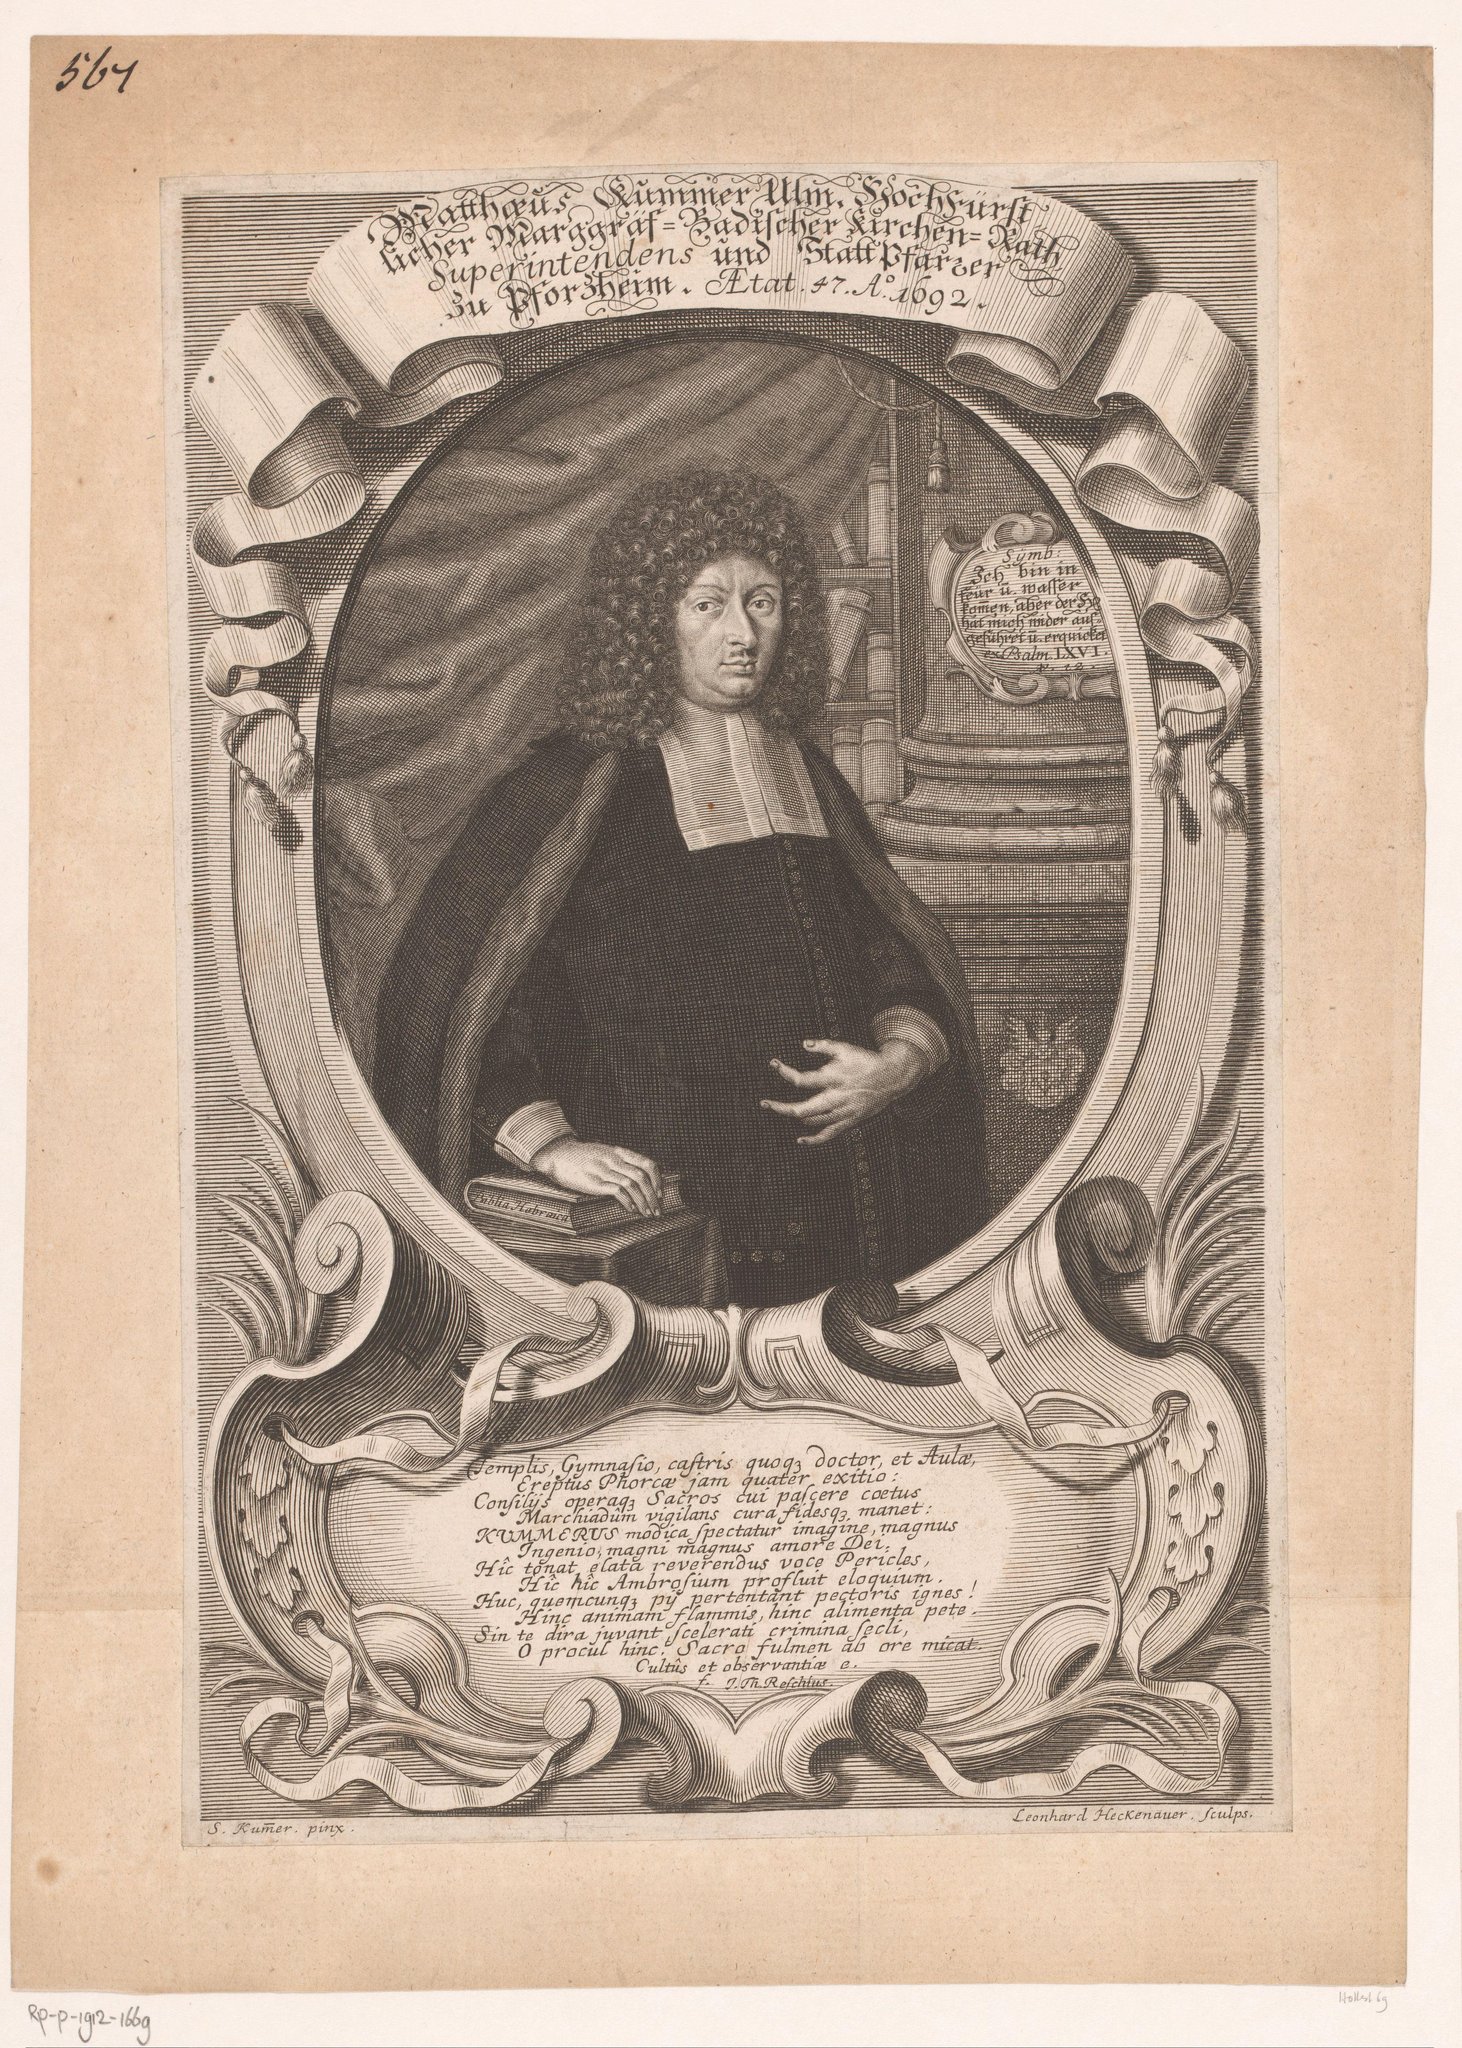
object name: print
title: Portret van Matthäus Kummer op 47-jarige leeftijd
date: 1660-1704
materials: paper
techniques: engraving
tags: bookshelves, historical persons, book, ornament ~ cartouche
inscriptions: collector's mark: Lugt 2228